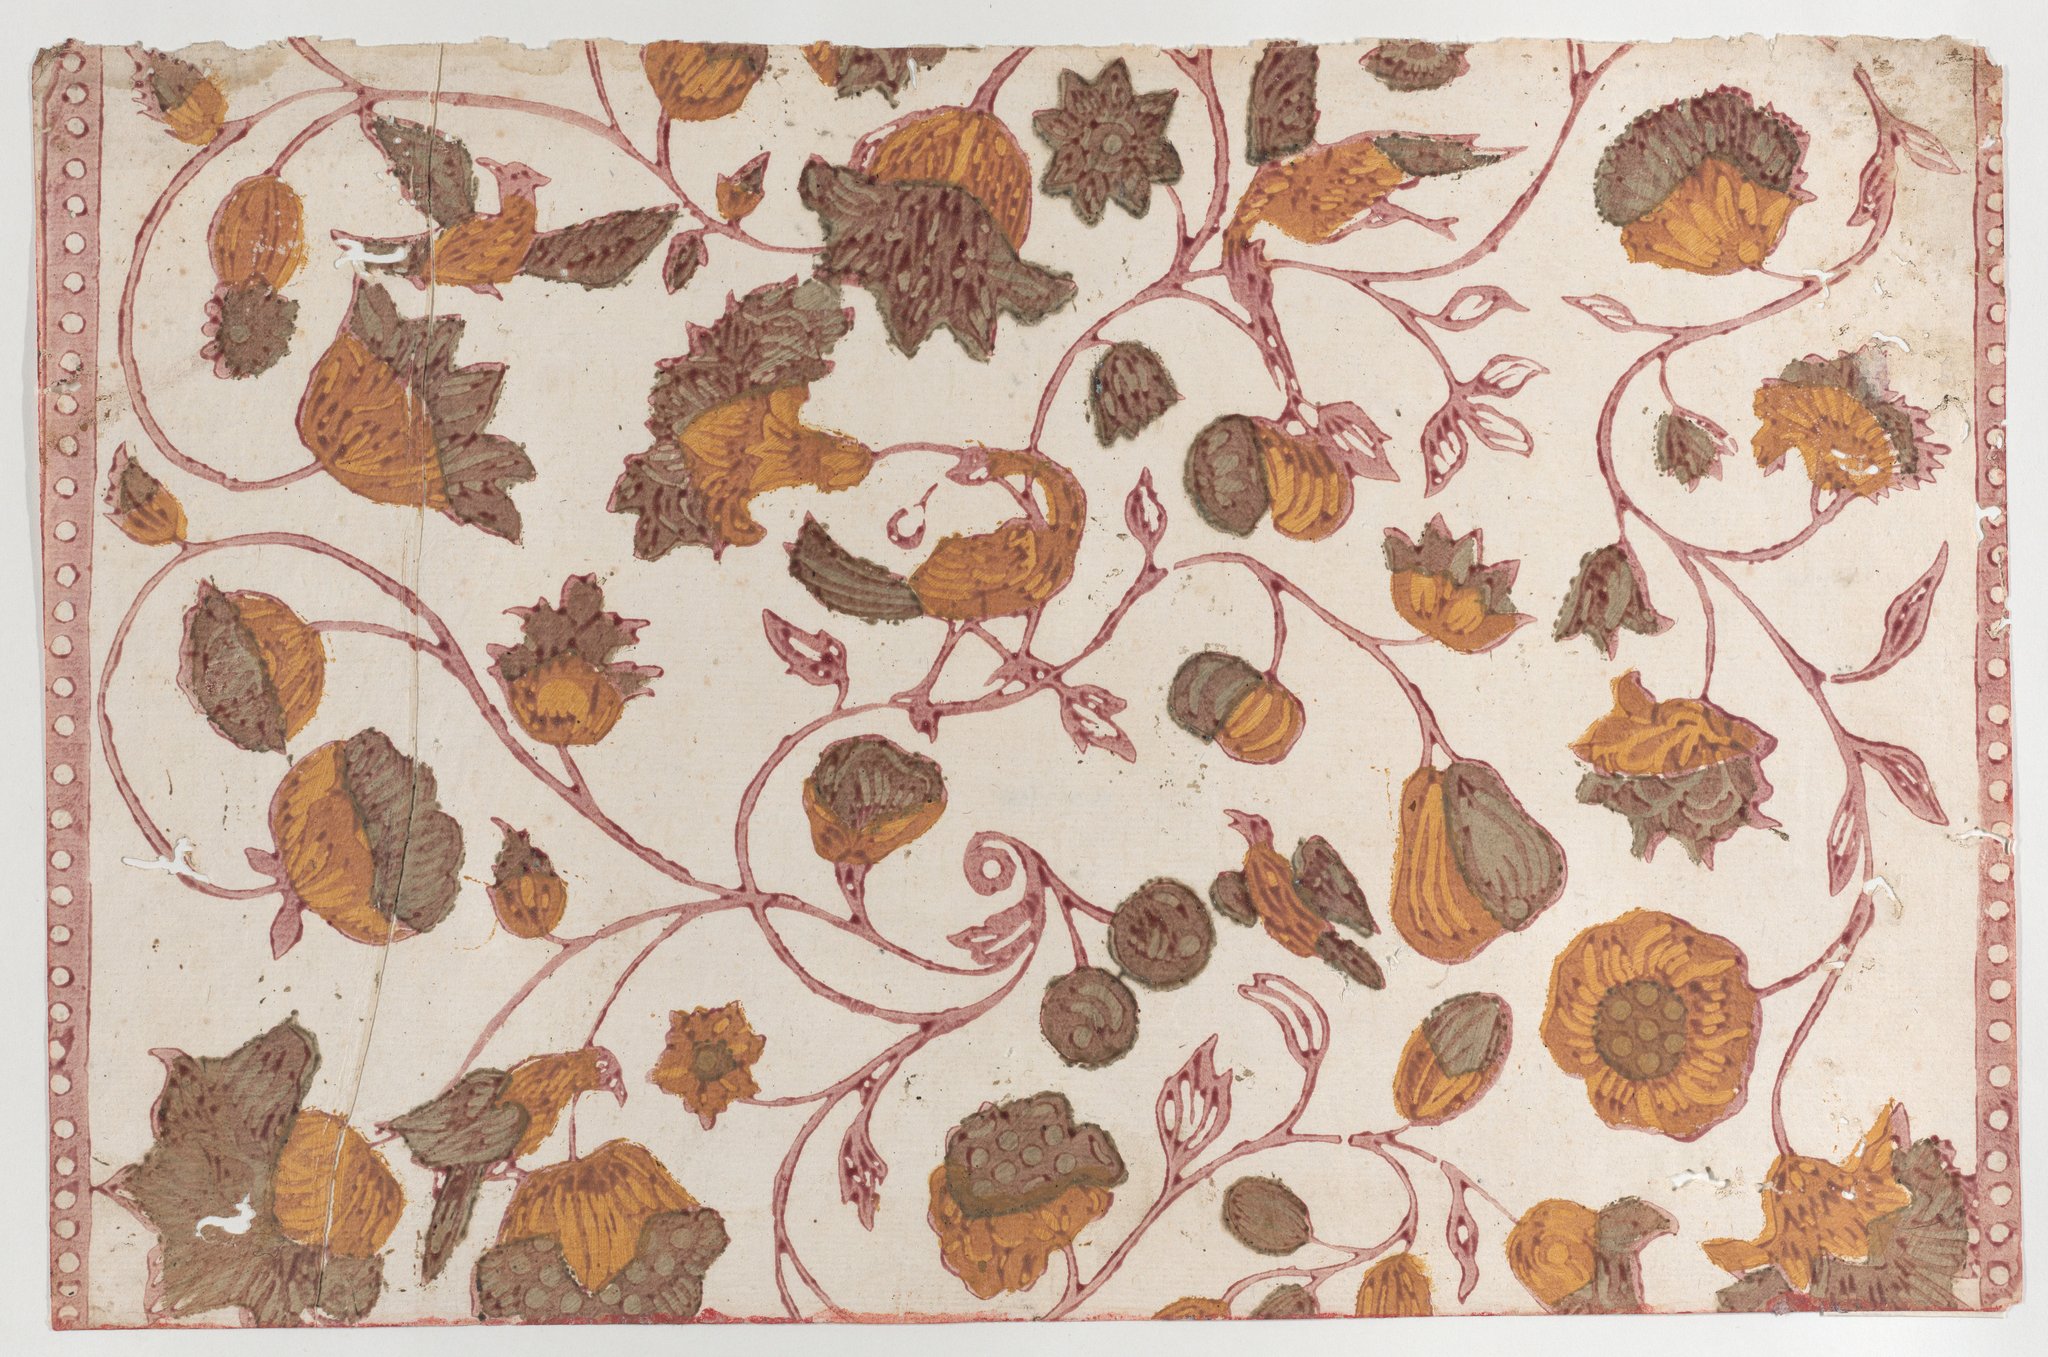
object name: print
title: Sheet with overall floral pattern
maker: Anonymous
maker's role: artist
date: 1701-1800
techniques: relief print